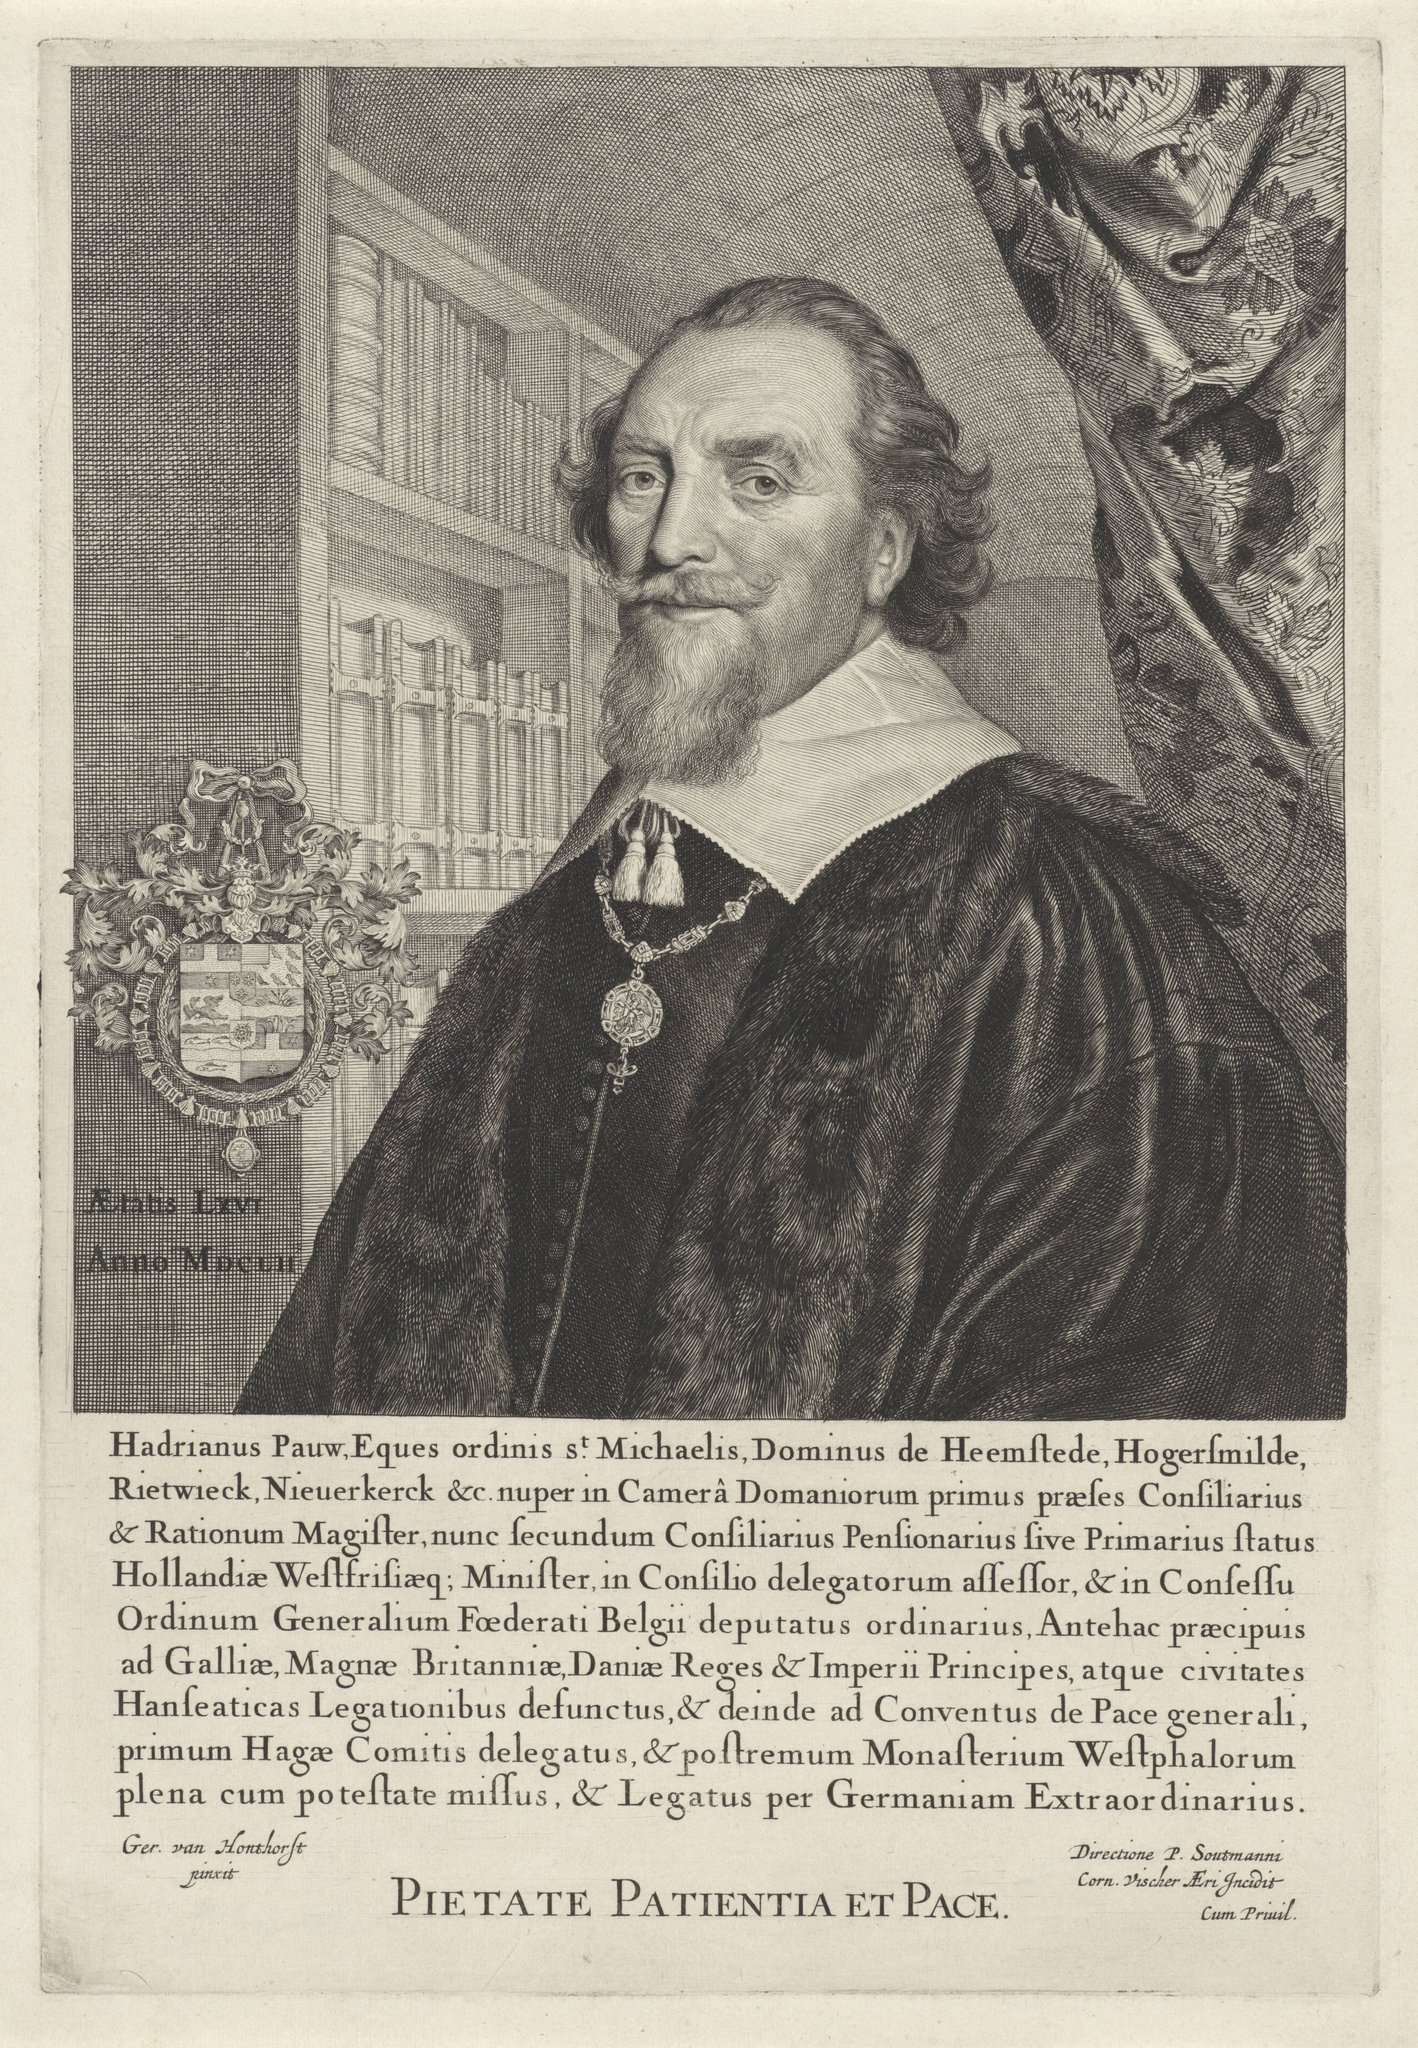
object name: print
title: Portret van Adriaen Pauw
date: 1652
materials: paper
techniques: engraving, etching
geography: haarlem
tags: amsterdam, politician, adriaen pauw (1585-1653), pendant, trinket, 'breloque', book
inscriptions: collector's mark: Lugt 240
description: Adriaen Pauw, heer van Heemstede en raadpensionaris van Holland, op 66-jarige leeftijd. Hij staat voor een boekenkast, waaraan een wapenschild hangt.